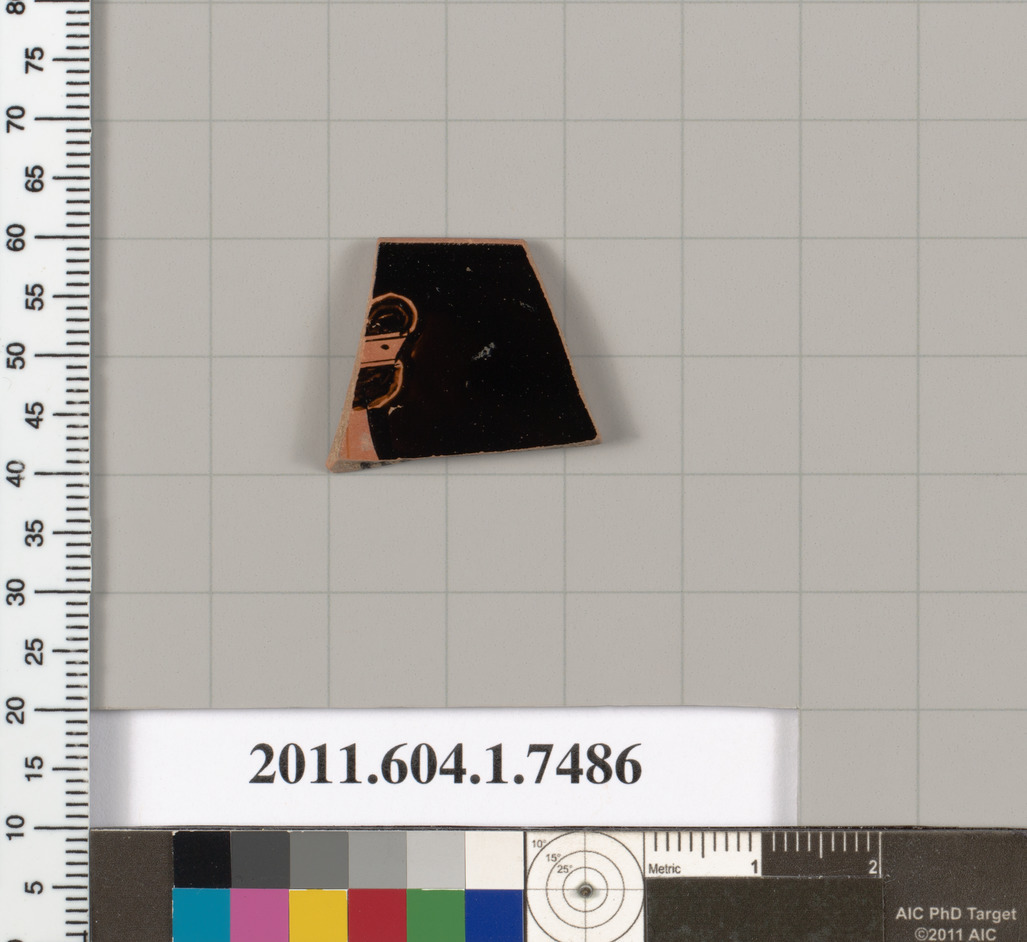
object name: kylix fragment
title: Terracotta rim fragment of a kylix (drinking cup)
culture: greek, attic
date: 460-450 BCE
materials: terracotta